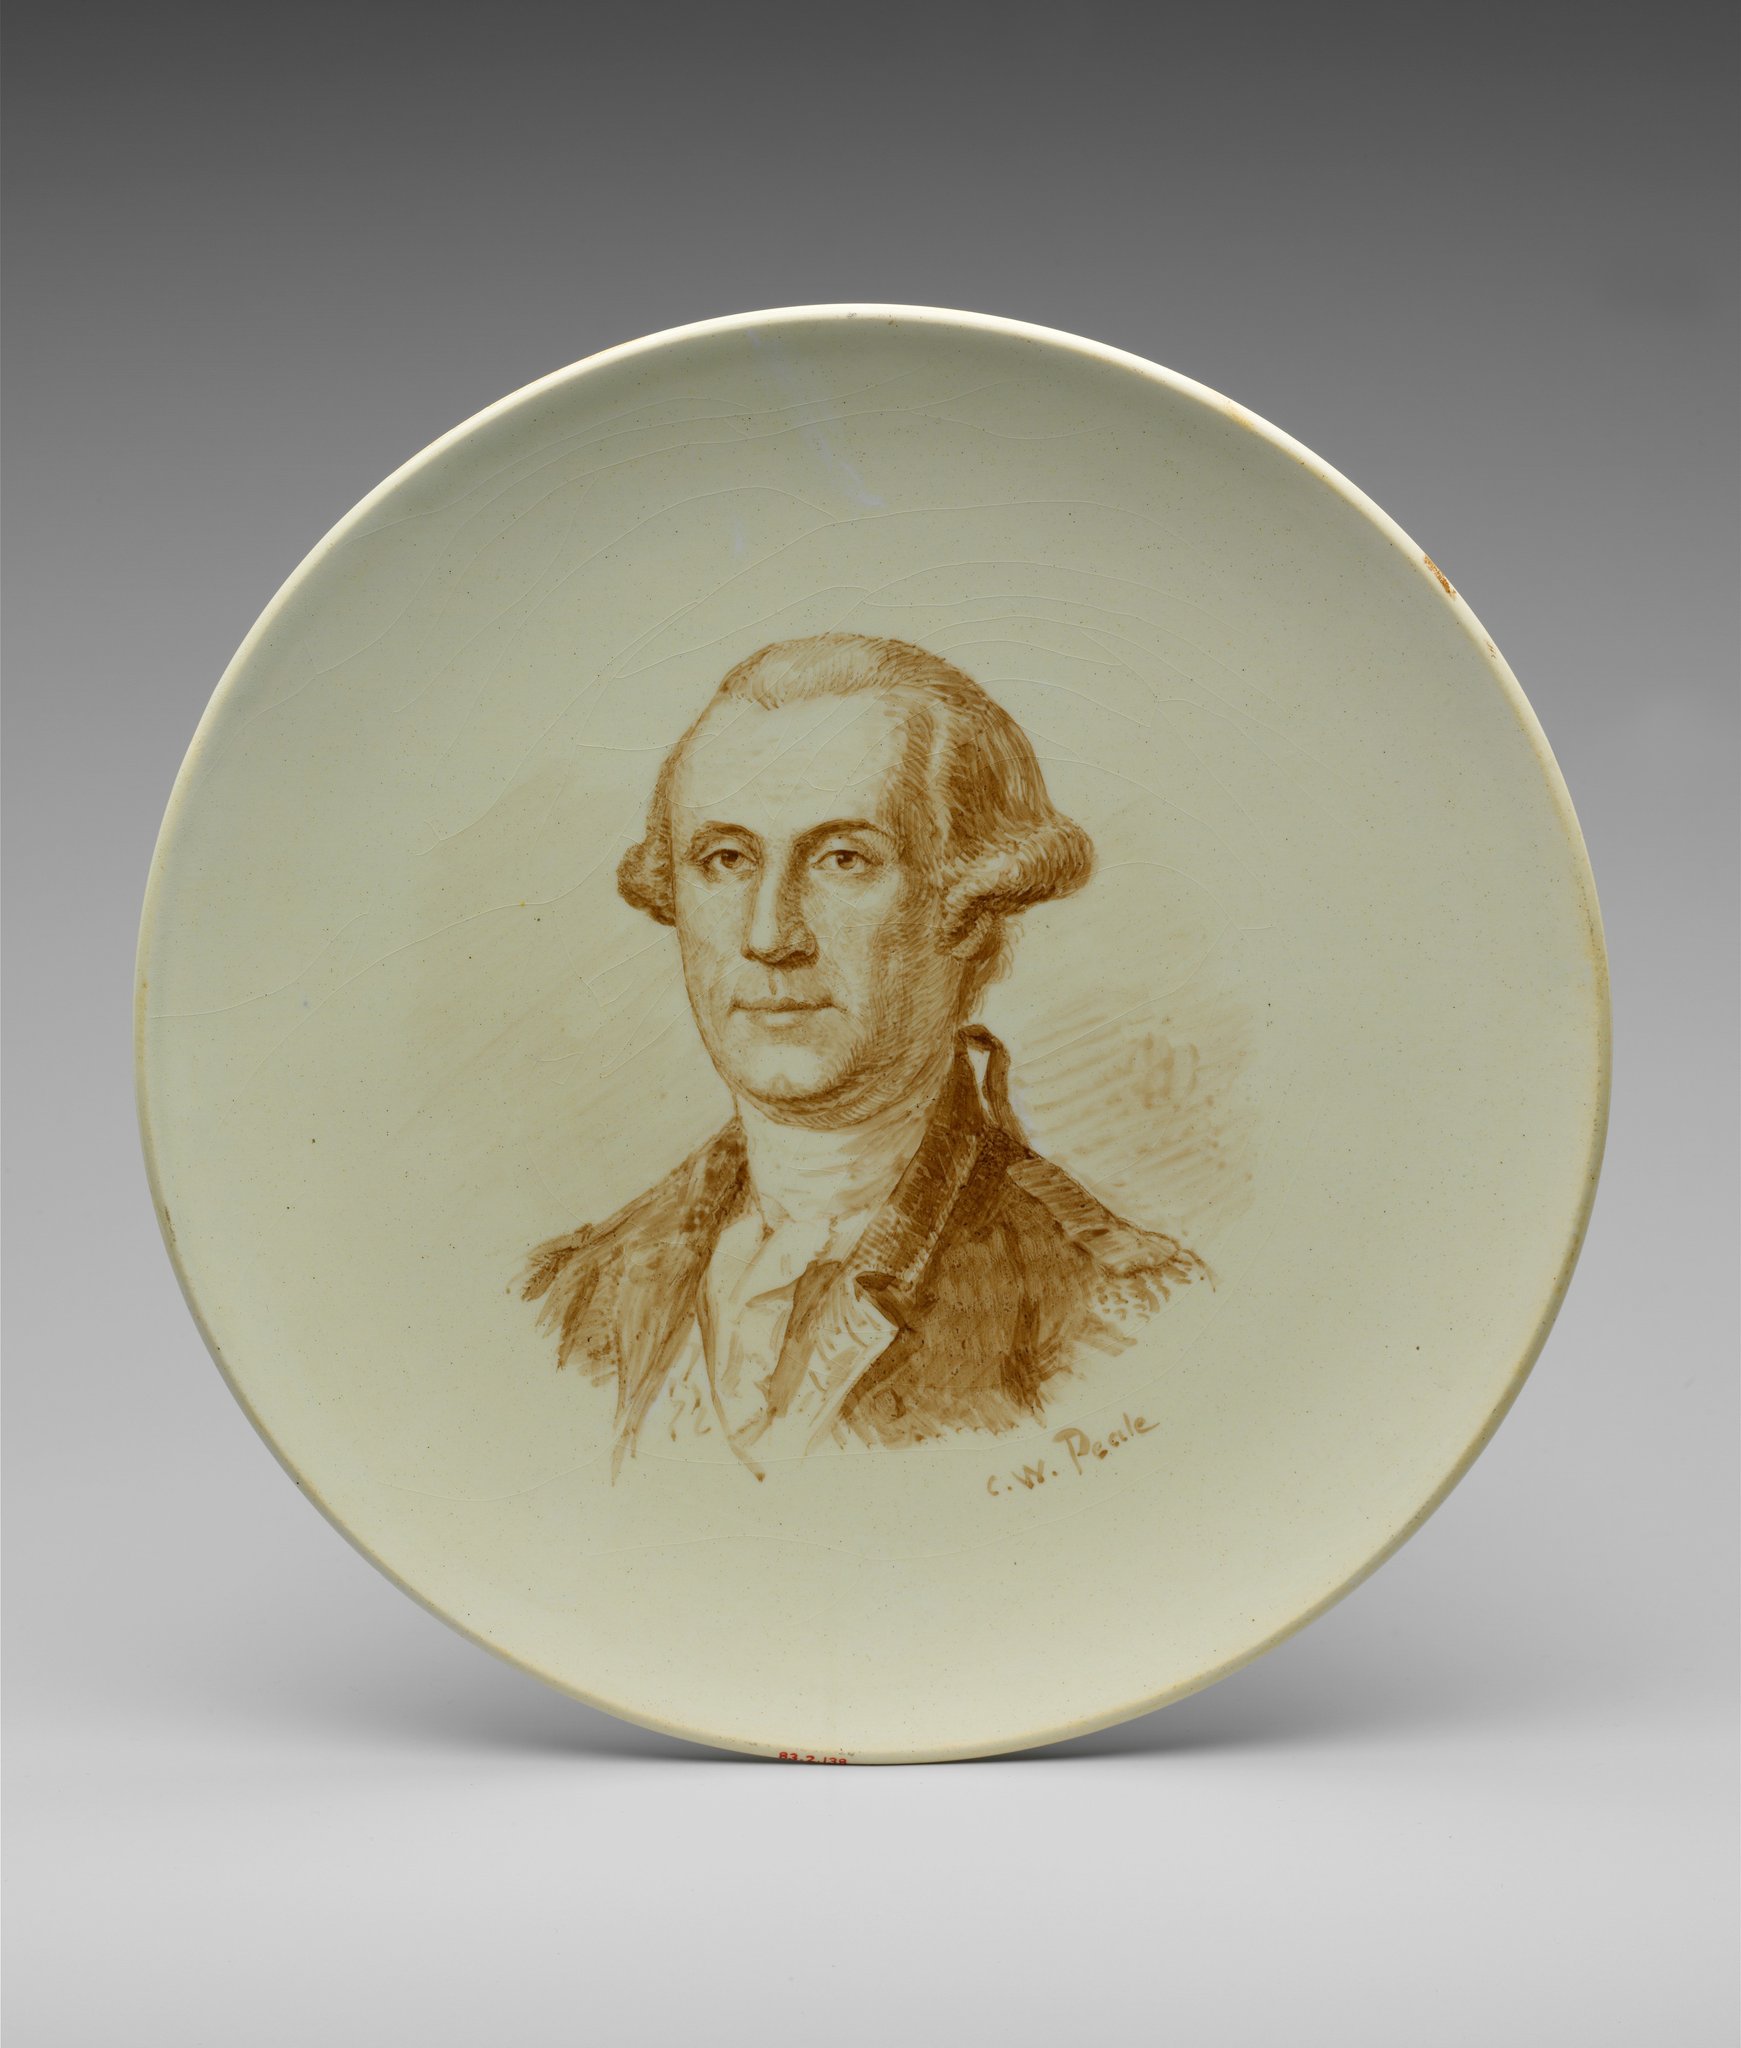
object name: plaque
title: George Washington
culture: french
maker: emile dupont-zipcy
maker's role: designer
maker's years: 1822-1885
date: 1840-1883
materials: faience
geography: france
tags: george washington,men,portraits